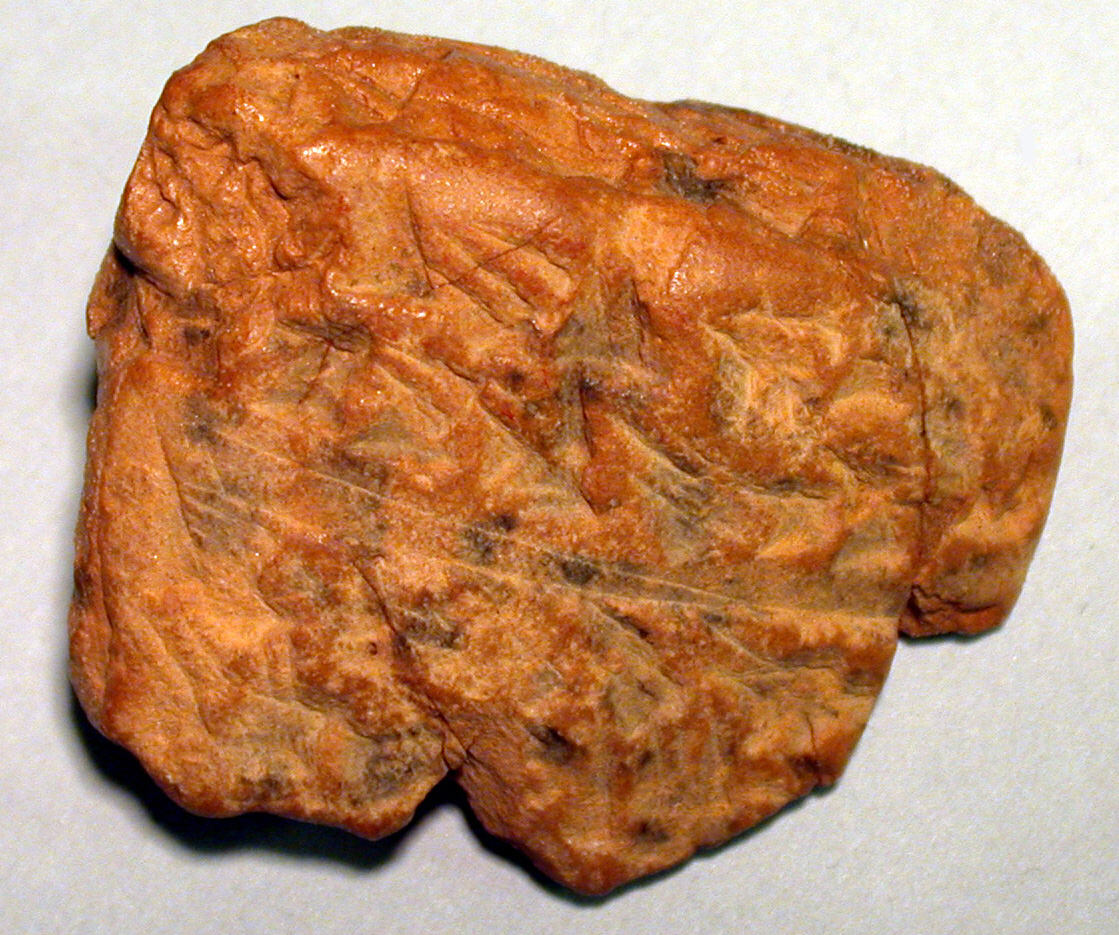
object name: cuneiform tablet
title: Cuneiform tablet: fragment, Ebabbar archive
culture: achaemenid or babylonian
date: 700-301 BCE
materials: clay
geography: mesopotamia